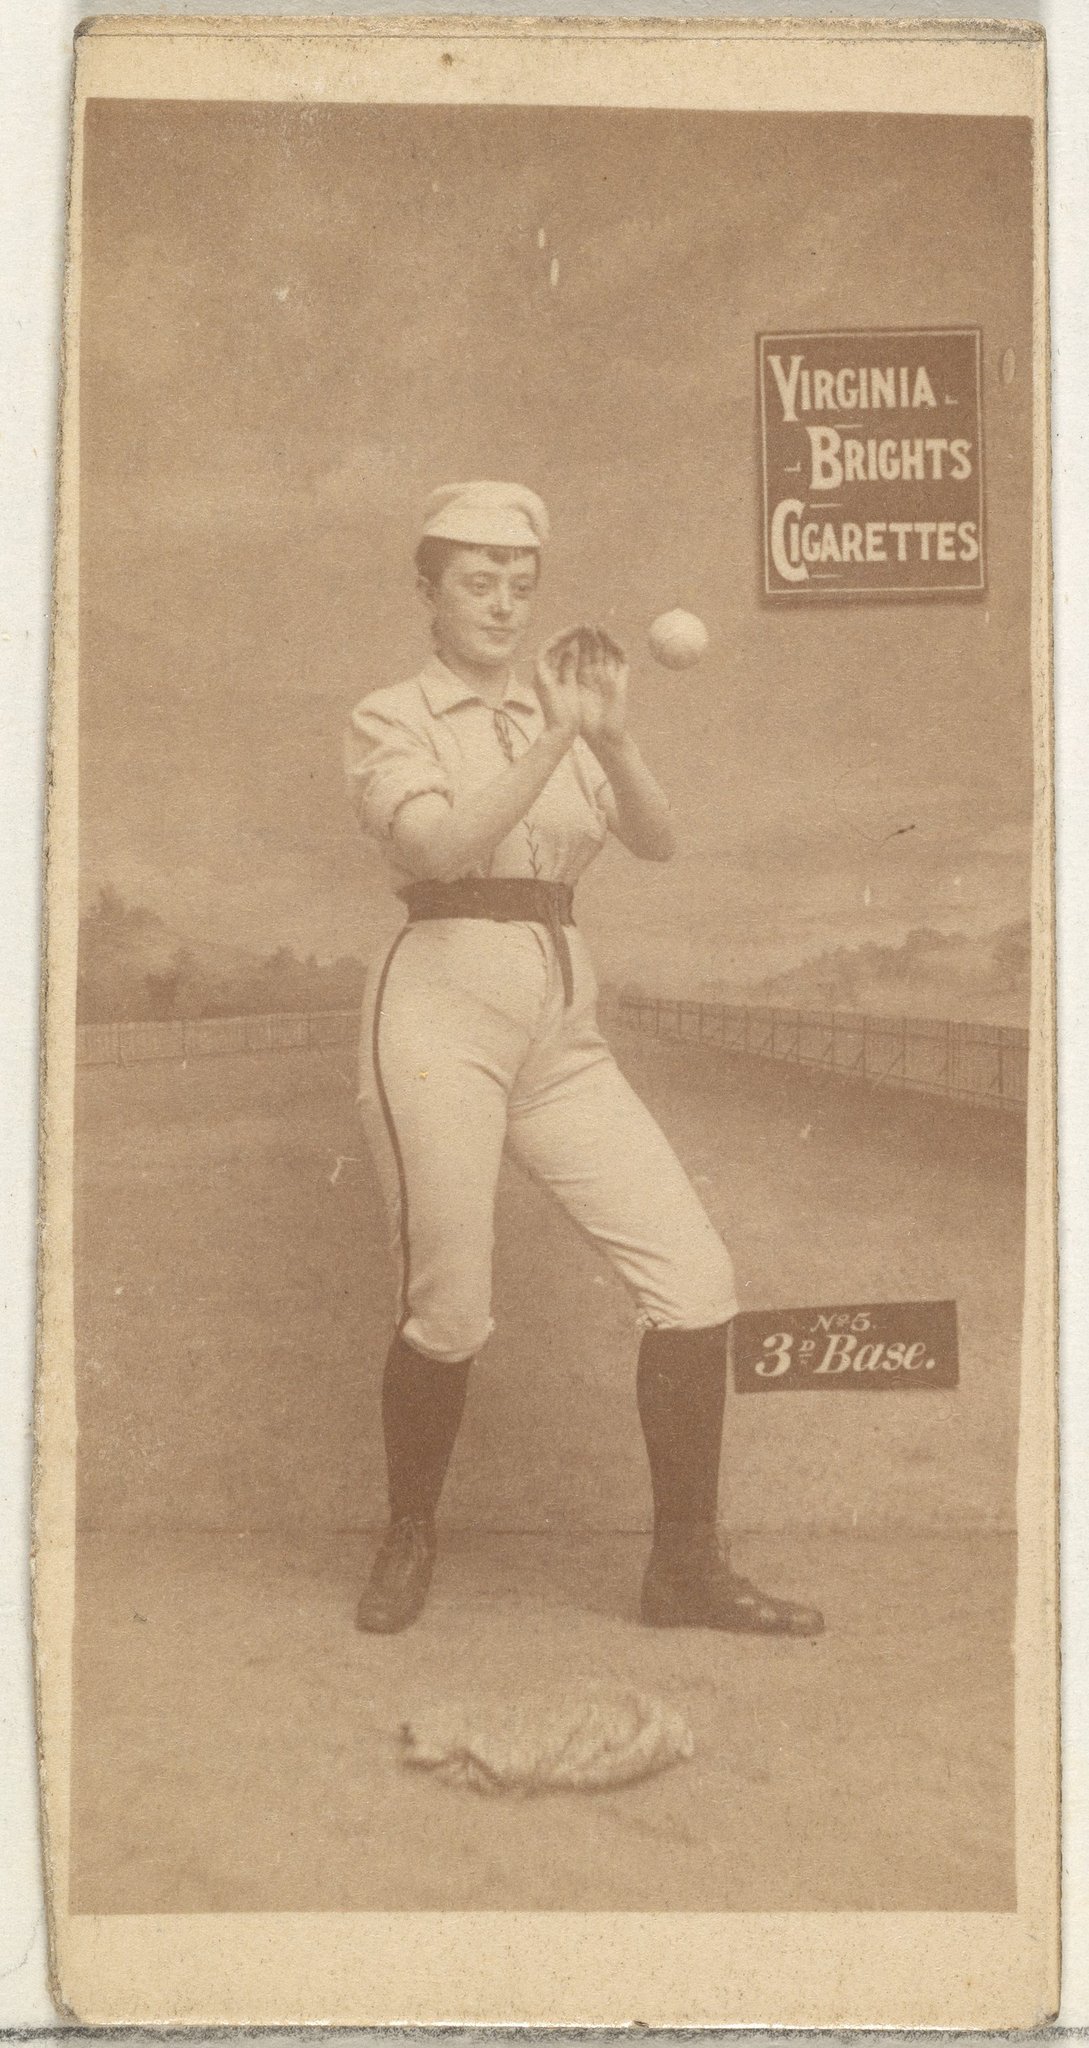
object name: baseball card, photograph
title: 3rd Base, from the Girl Baseball Players series (N48, Type 2) for Virginia Brights Cigarettes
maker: allen & ginter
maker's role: publisher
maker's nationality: american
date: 1886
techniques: albumen silver print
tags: portraits,women,baseball,athletes